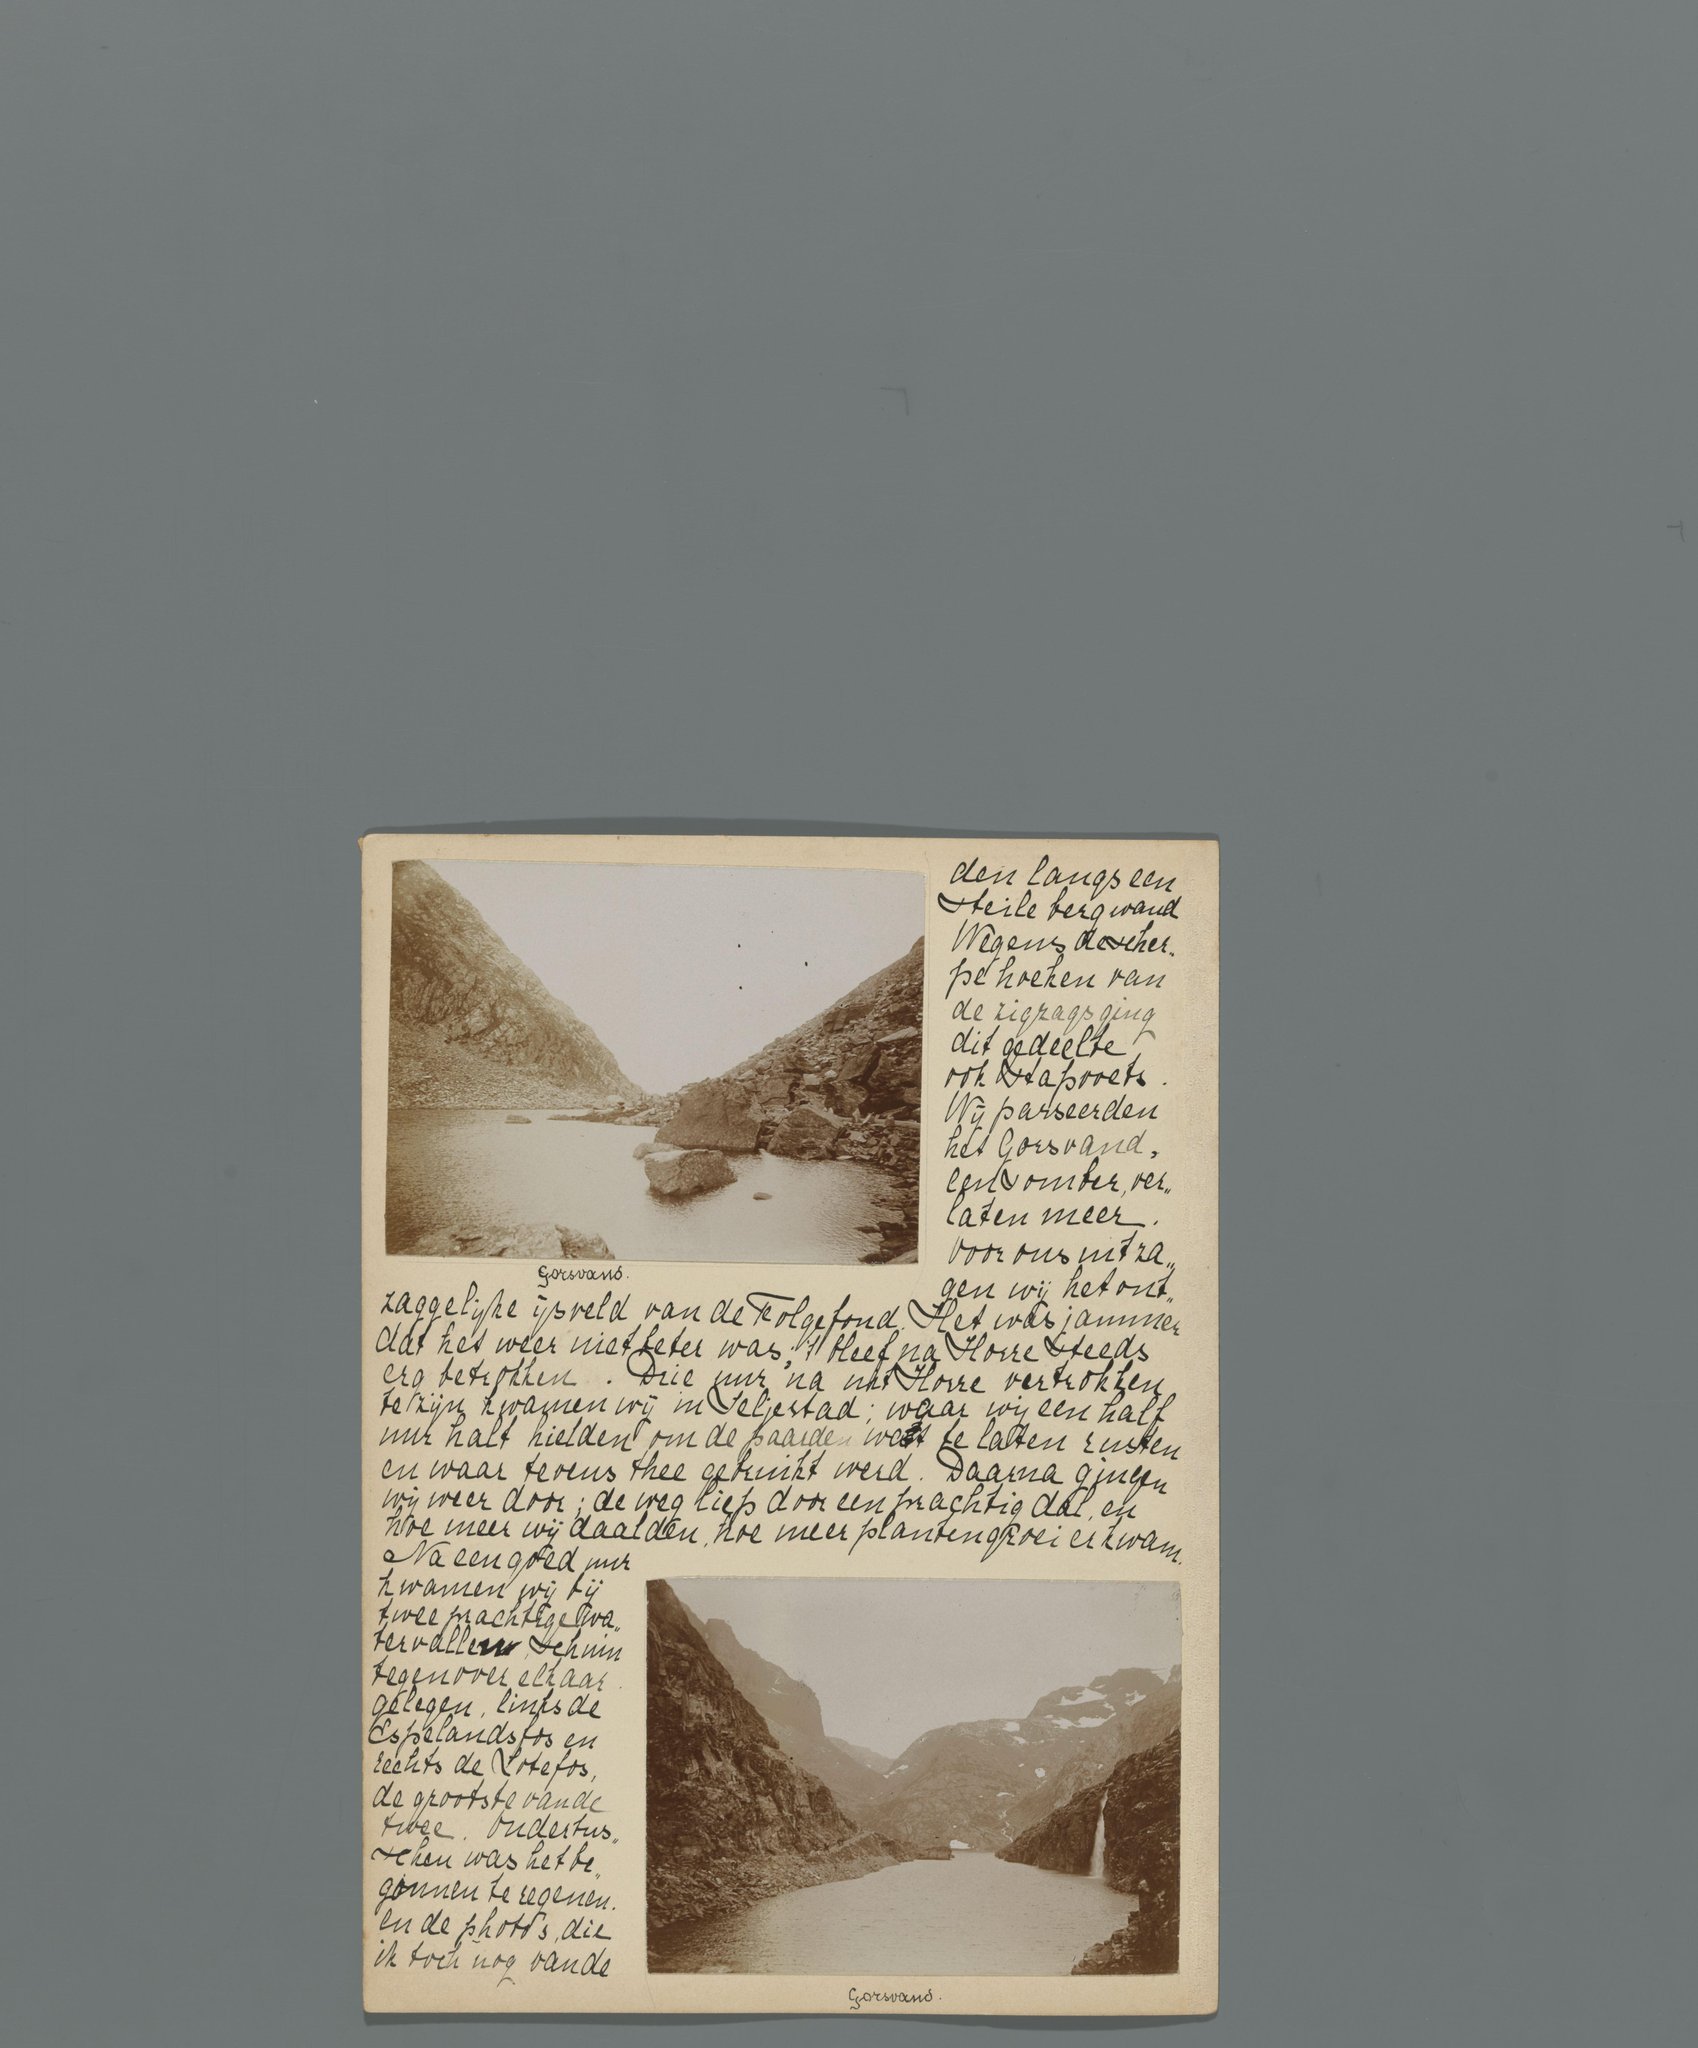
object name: photograph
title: Achttiende pagina van een dagboek van een reis door Noorwegen met twee foto's van het Gorsvandmeer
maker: hendrik herman van den berg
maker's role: amateurfotograaf, jurist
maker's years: 1875-1944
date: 1895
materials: paper, ink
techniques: pen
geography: norway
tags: amsterdam, hendrik herman van den berg, waterfall, handwriting, written text, lake, 'en route', traveller under way, mountains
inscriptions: caption: ‘Gorsvand./ Gorsvand.’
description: Achttiende pagina van een dagboek met het verslag van een reis door Noorwegen gemaakt door Hendrik Herman van den Berg en zijn neef Guillaume Louis Jacques Holle tussen 5 en 20 juli 1895. Op het dagboekblad zijn twee foto's geplakt met gezichten op het Gorsvandmeer.